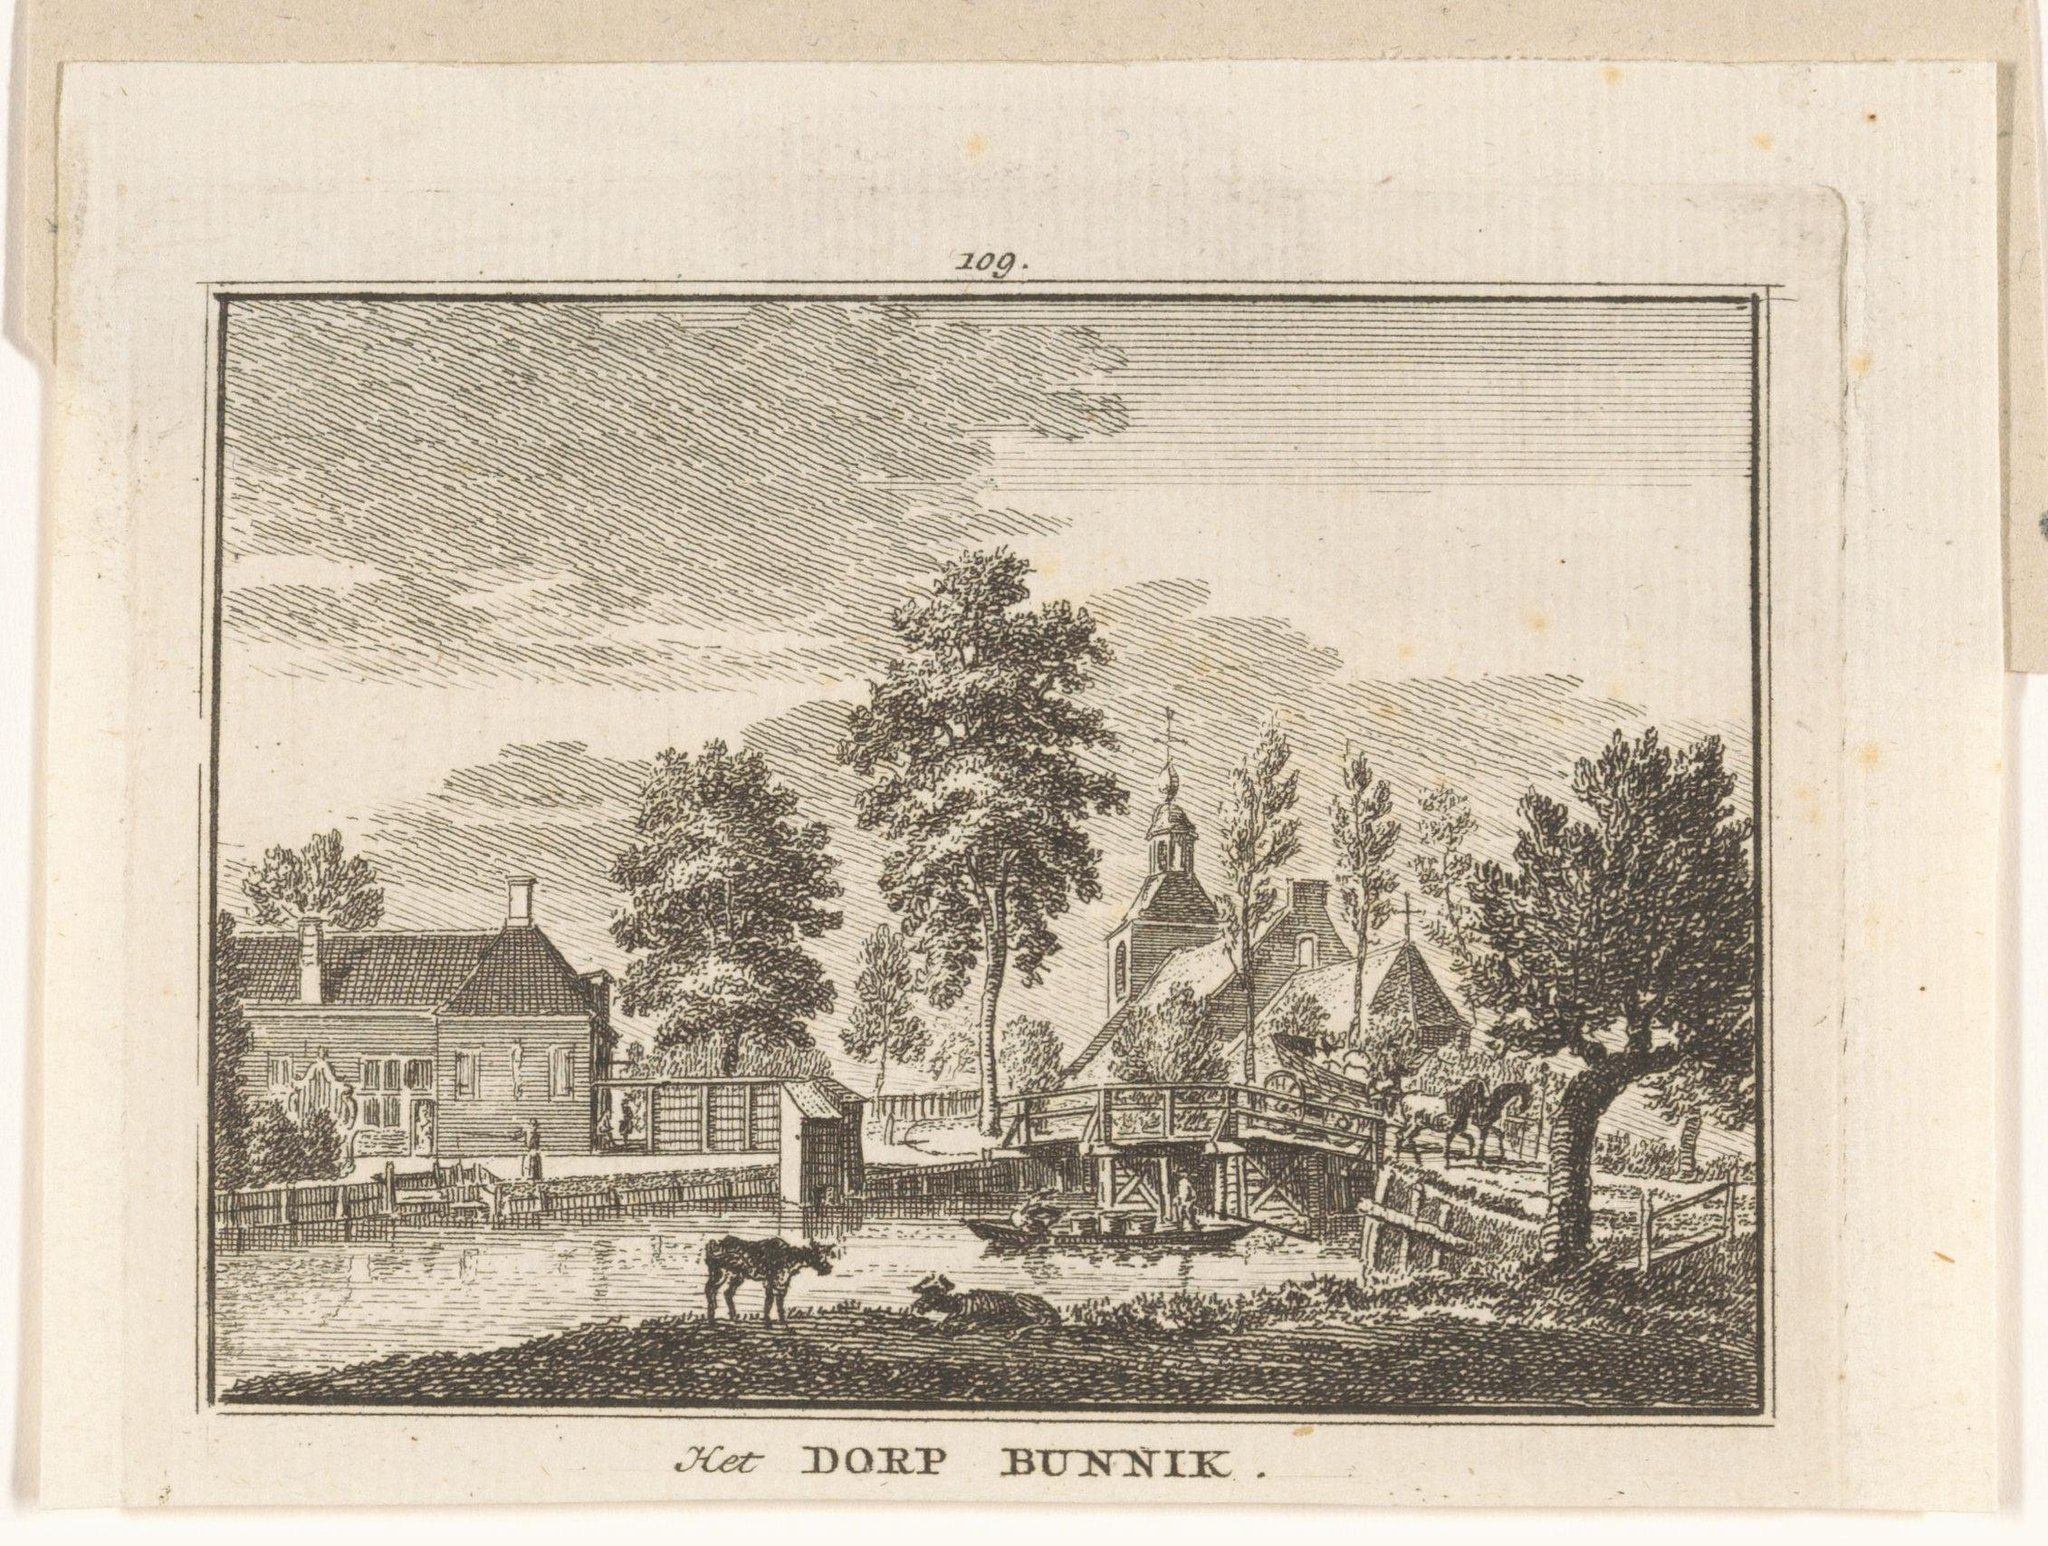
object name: print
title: Gezicht op Bunnik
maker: hendrik spilman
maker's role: draughtsman, painter, print maker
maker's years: 1721-1784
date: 1773-1792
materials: paper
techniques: engraving, etching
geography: haarlem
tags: bridge (+ view ~ vehicle, ship, etc.), church (exterior)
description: Prent ook gebruikt in: Het verheerlykt Nederland of kabinet van hedendaagsche gezigten van steden, dorpen (…). 9 delen. Amsterdam: Isaak Tirion en weduwe Isaak Tirion, 1745-1774, dl. 7, 8 of 9 (weduwe Isaak Tirion, 1773-1774), ill. 109. Of in: Nederlandsche tafereelen; of eene keurige verzameling van negen honderd fraaije gezigten van steden, dorpen, sloten, oudheden (….). 9 delen. Amsterdam: Jan de Groot, 1792, dl. 7, 8 of 9, ill. 109. Uit welke druk het huidige exemplaar precies komt is niet na te gaan.